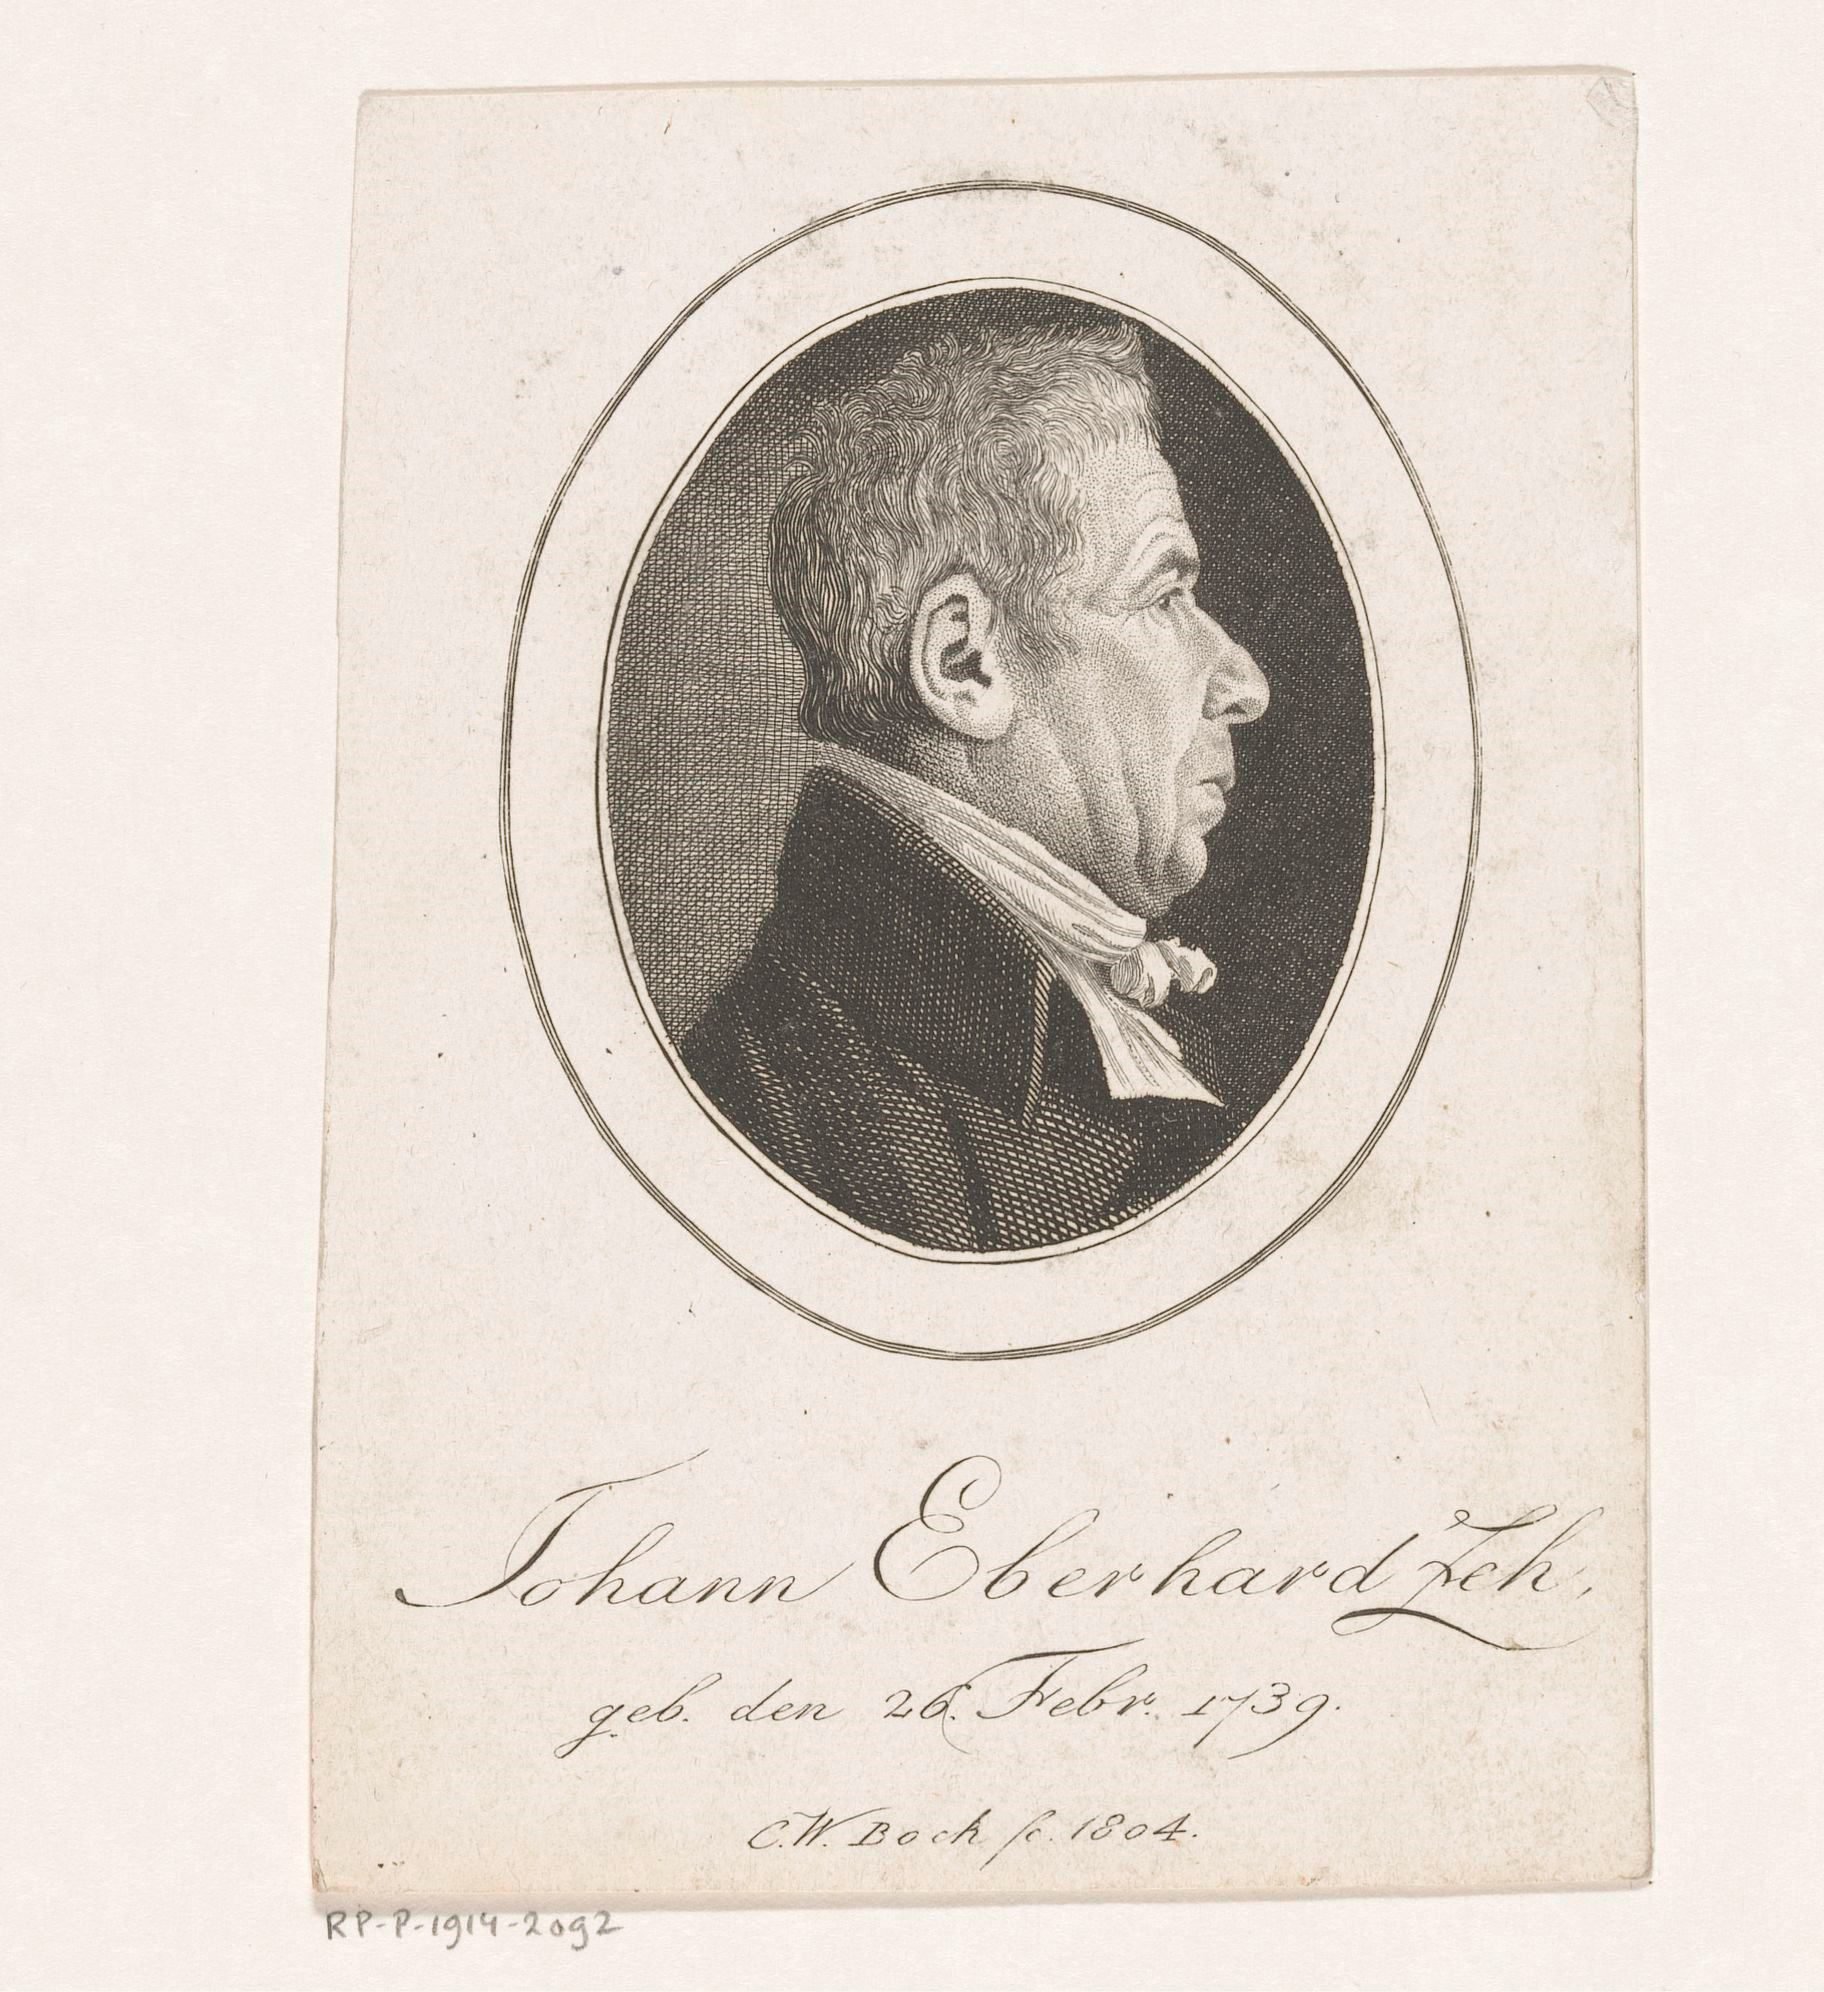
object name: print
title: Portret van Johann Eberhard Zeh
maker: christoph wilhelm bock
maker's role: print maker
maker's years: 1755-1836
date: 1804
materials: paper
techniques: engraving, etching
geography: nuremberg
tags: auctioneer, historical persons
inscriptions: collector's mark: Lugt 2228